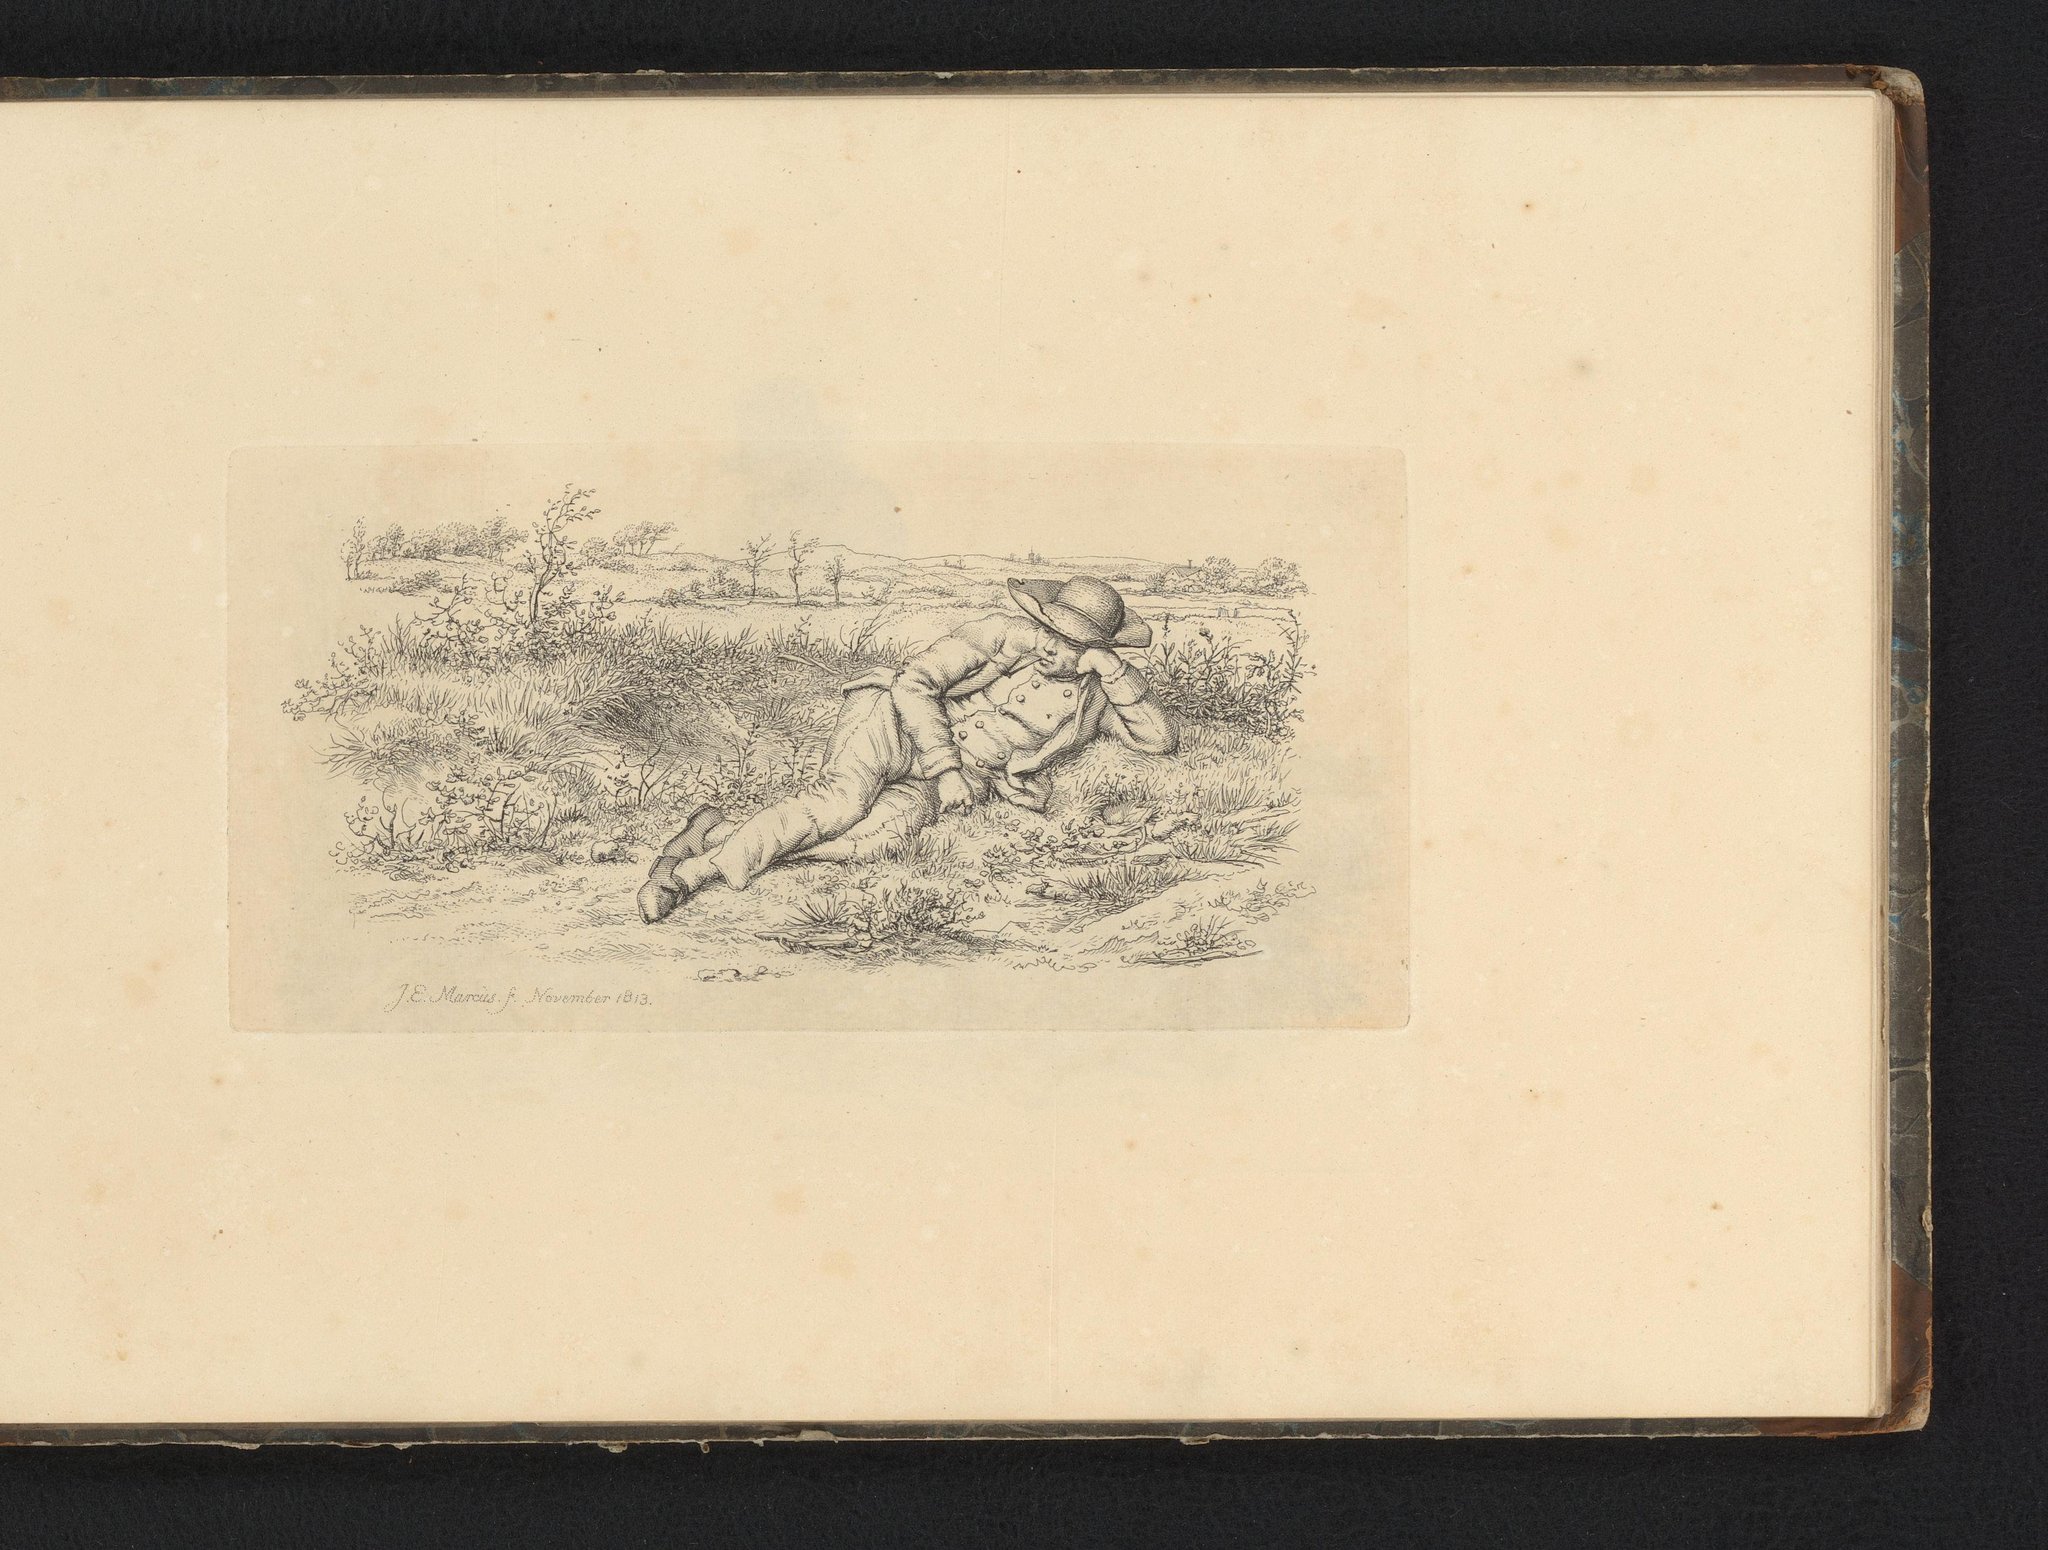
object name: print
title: Studiebeelden en fragmenten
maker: jacob ernst marcus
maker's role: draughtsman, print maker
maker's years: 1774-1826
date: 1811-1813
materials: paper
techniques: etching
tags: pipe ~ tobacco, sleeping on the ground, resting - bb - out of doors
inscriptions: date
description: Deze prent maakt deel uit van een album.